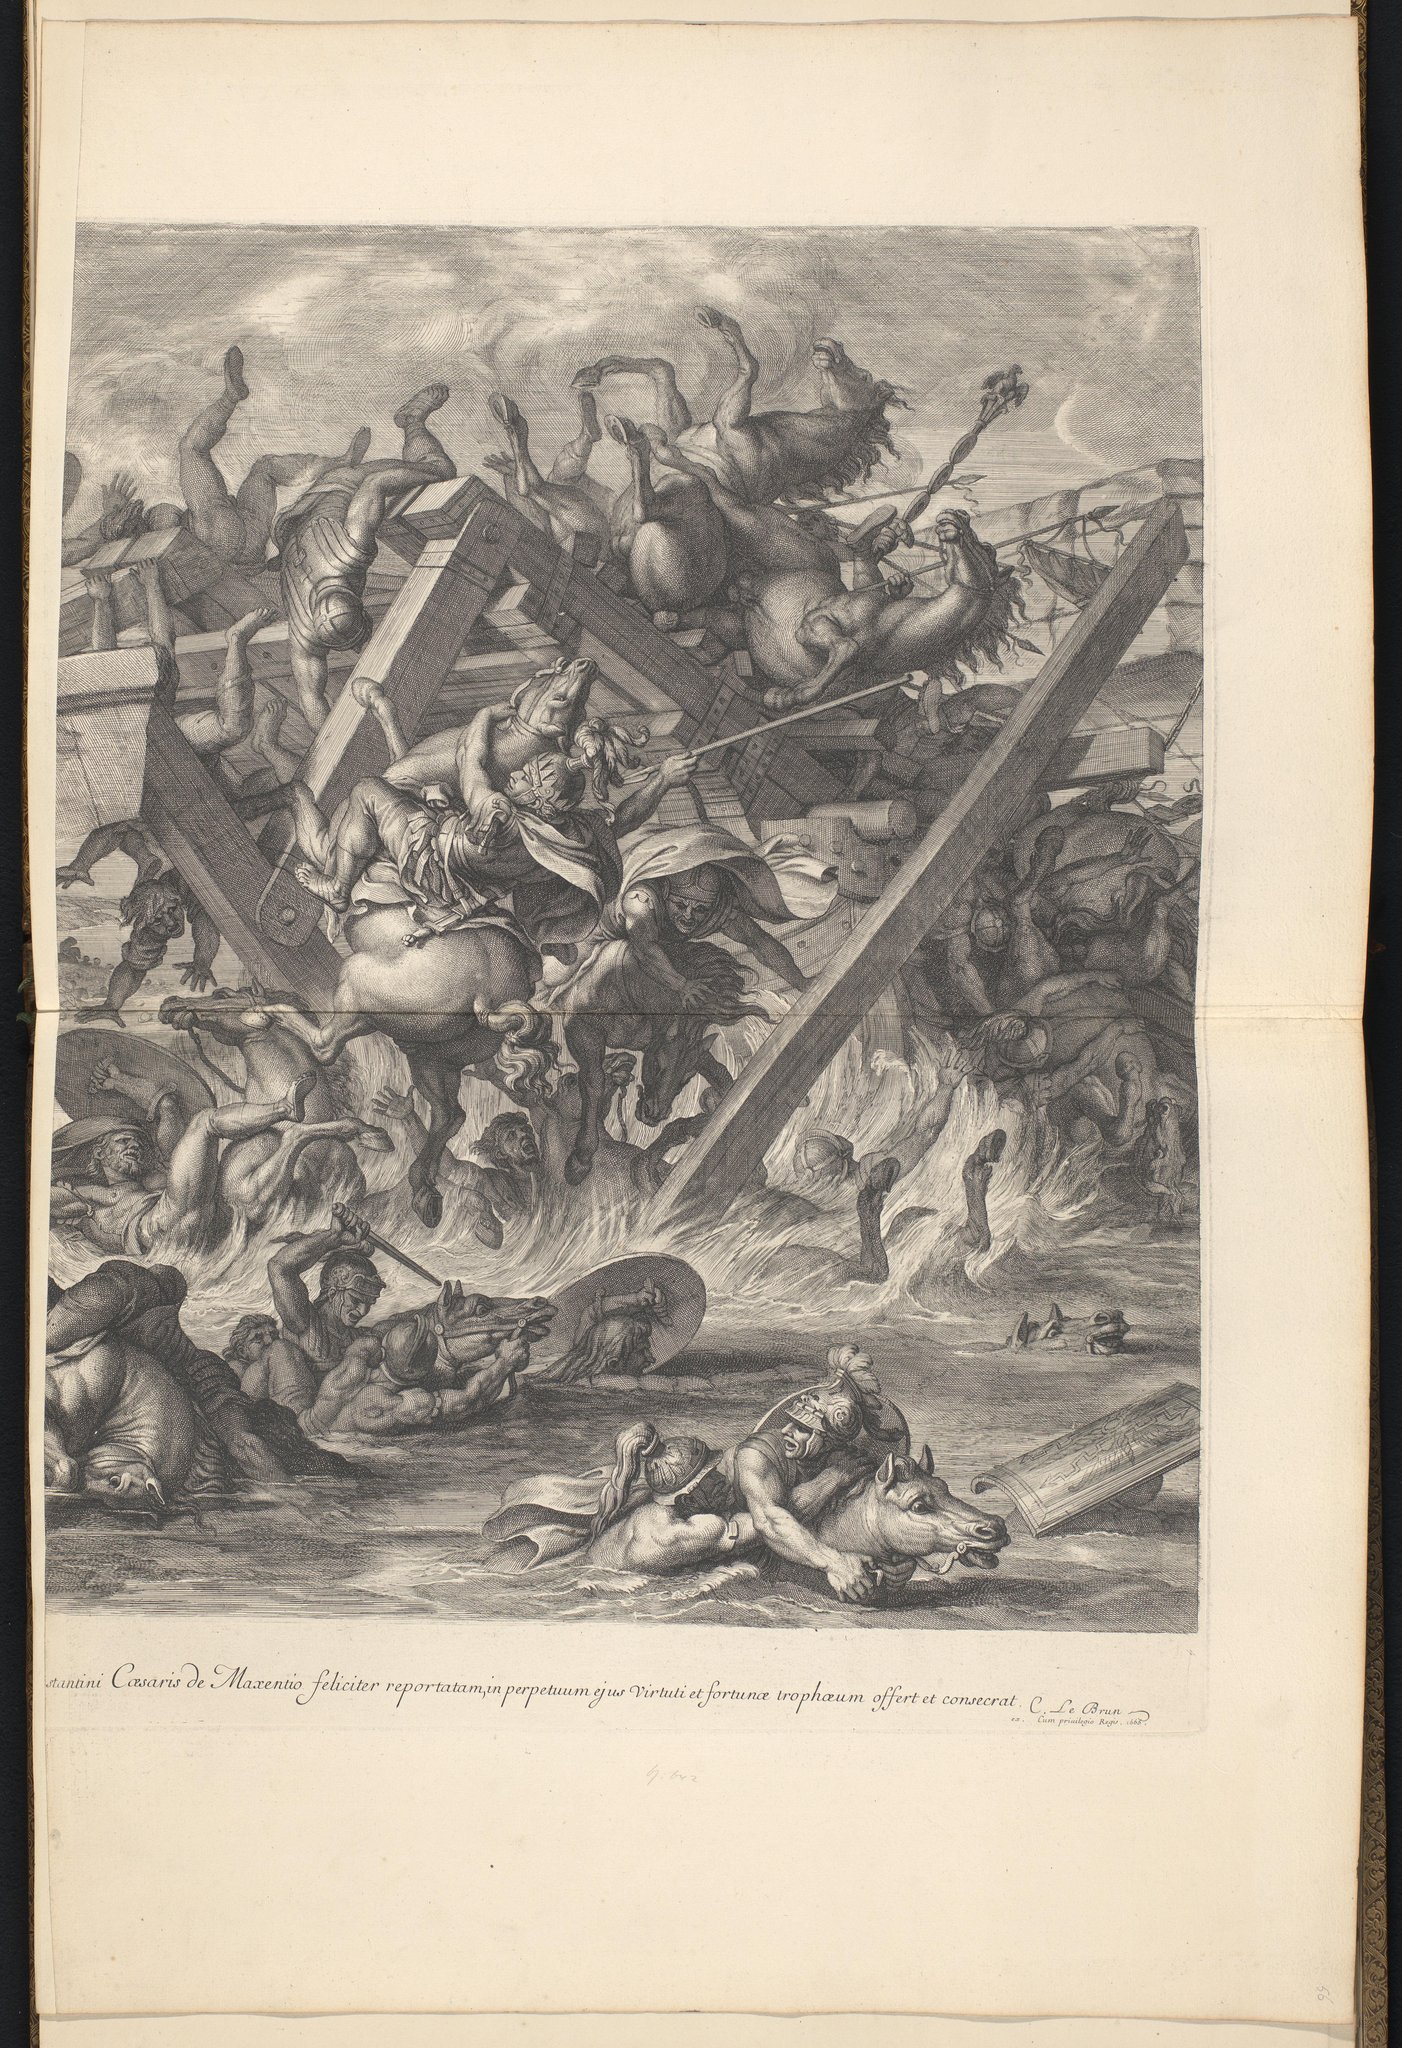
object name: print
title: Werken van Charles le Brun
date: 1666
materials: paper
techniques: engraving, etching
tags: the battle of the milvian bridge (saxa rubra): st. constantine on horseback confronts maxentius; a cross appears in the sky with in fiery letters 'in hoc signo vinces' (the raised standards of the roman soldiers carry a cross or the chi-rho monogram), rome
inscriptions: date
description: Rechter blad van een prent gedrukt van drie platen.